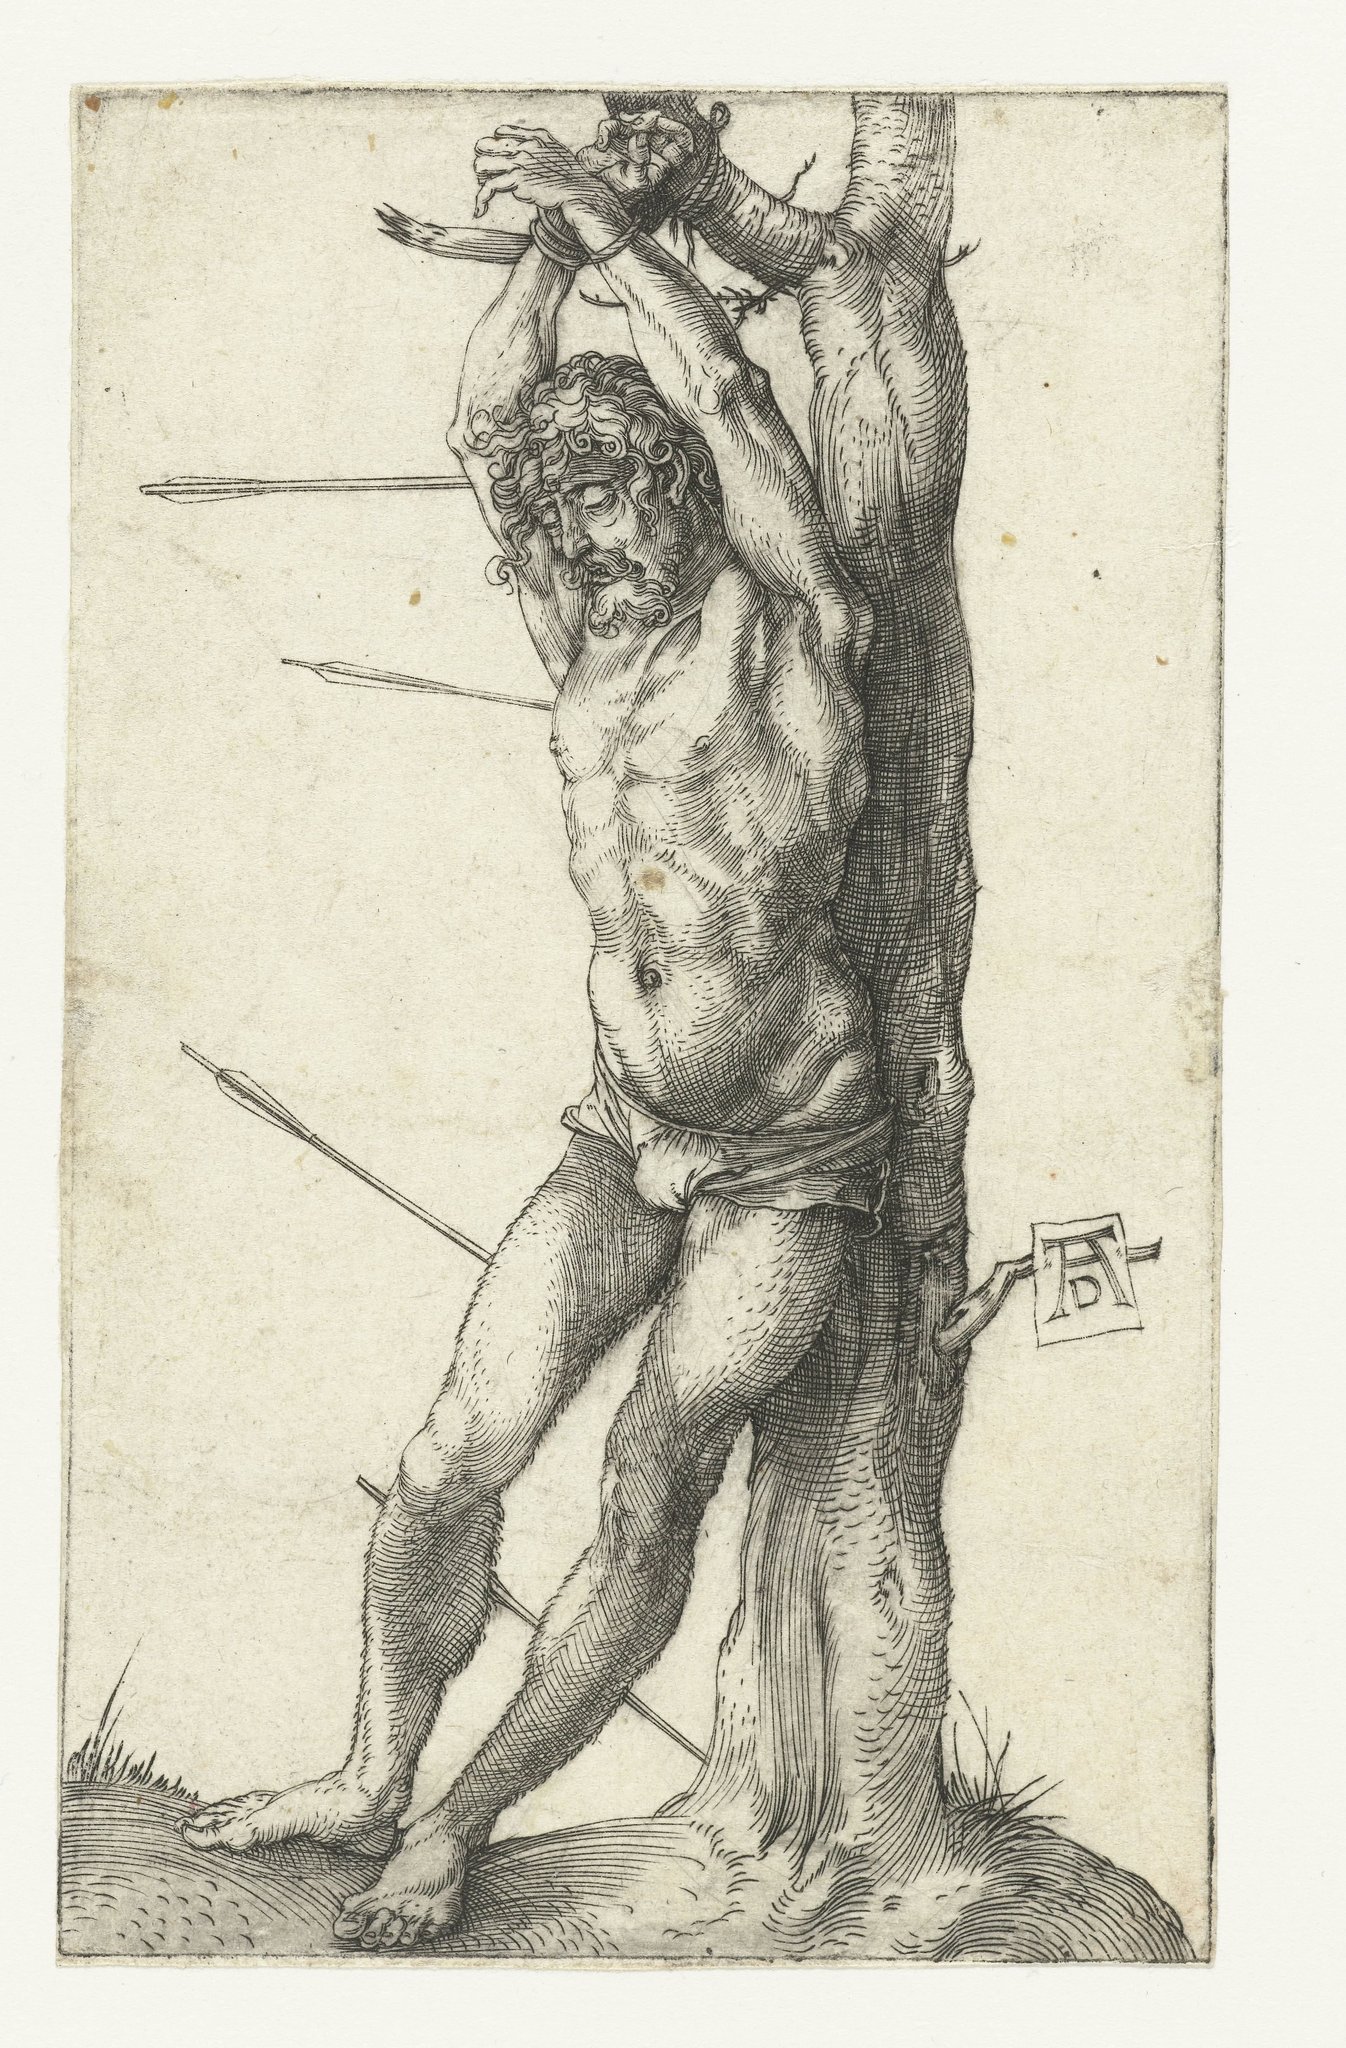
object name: print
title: De Heilige Sebastiaan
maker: albrecht dürer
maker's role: draughtsman, painter, print maker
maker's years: 1471-1528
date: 1499-1503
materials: paper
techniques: engraving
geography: nuremberg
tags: st. sebastian, tied to a tree or a pillar, is pierced by arrows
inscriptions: collector's mark: Lugt 2228a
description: De Heilige Sebastiaan, gebonden aan een boom, pijlen in zijn lichaam.